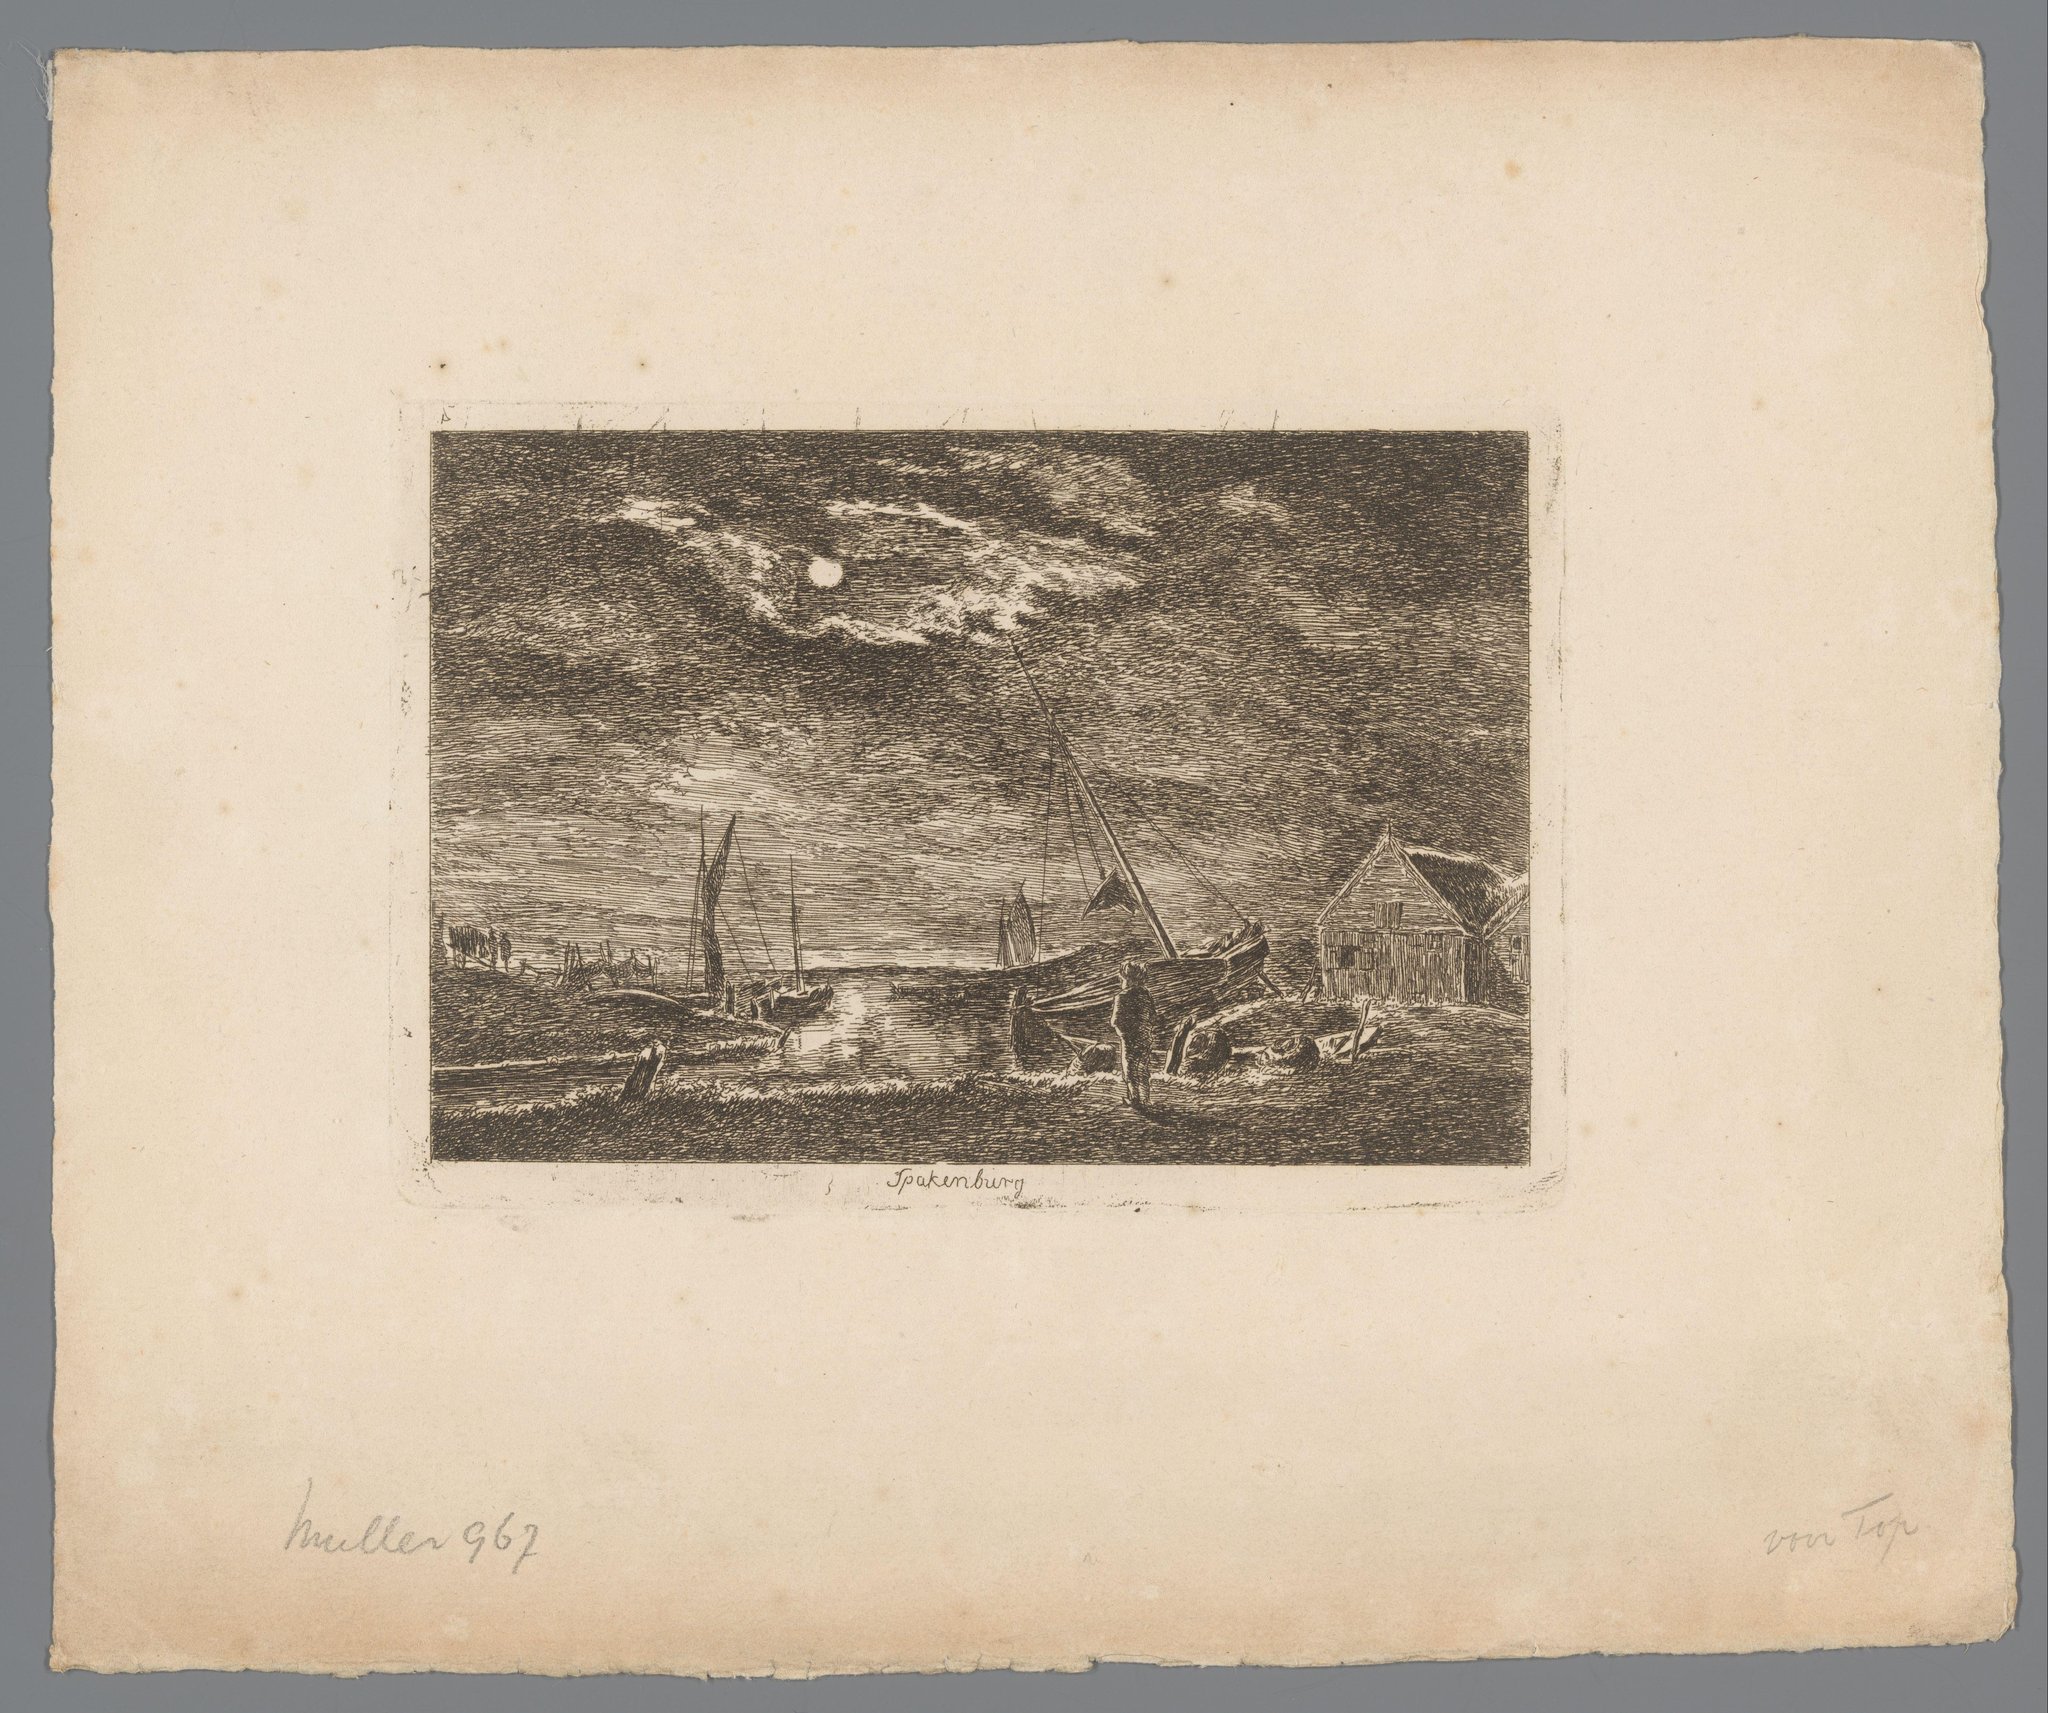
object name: print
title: Verschijden Landschappen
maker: hermanus van brussel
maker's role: draughtsman, print maker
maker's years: 1763-1815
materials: paper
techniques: etching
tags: sailing-ship, sailing-boat, moonlight, night ~ landscape (sometimes titled 'nox')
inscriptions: collector's mark: Lugt 2233